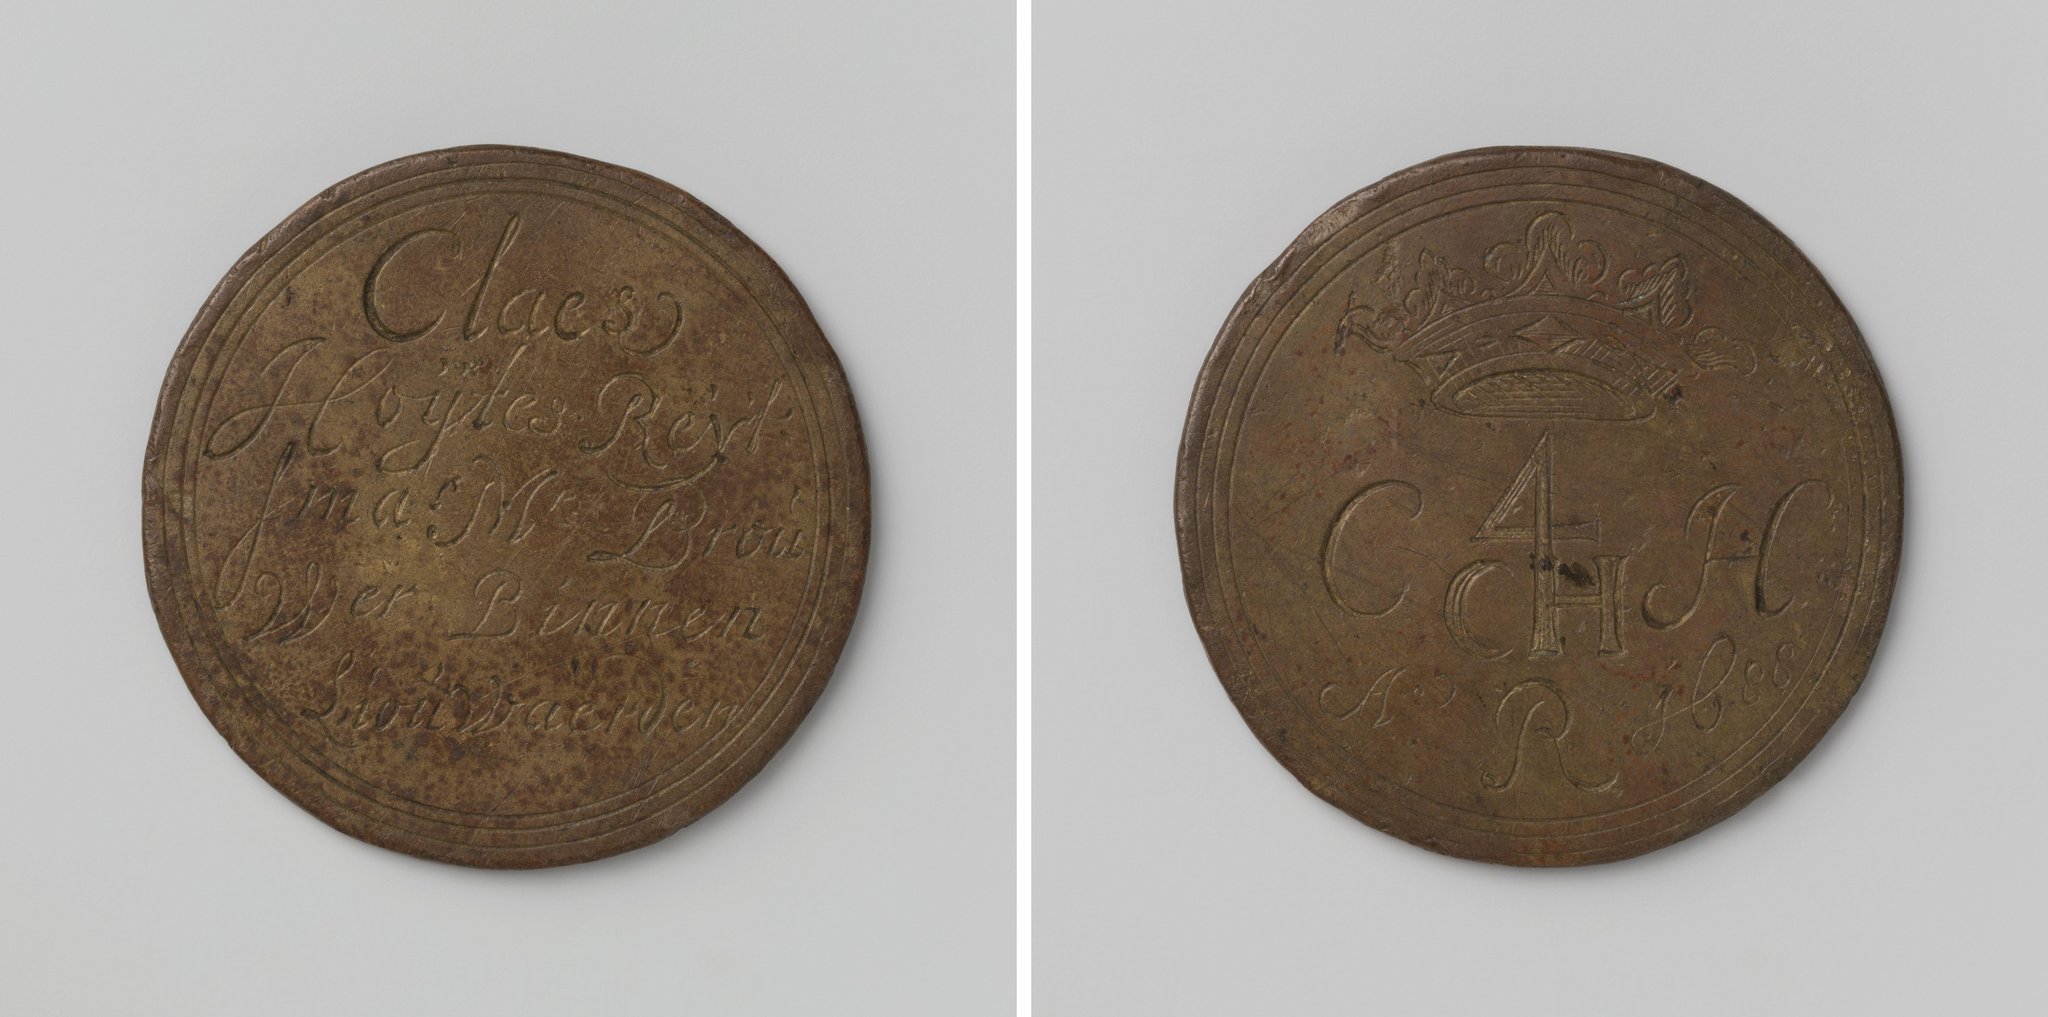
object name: medal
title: Brouwersgilde van Leeuwarden, gildepenning van Claes Hoytes Reytsma, meester brouwer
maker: Anonymous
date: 1688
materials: brass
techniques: engraving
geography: leeuwarden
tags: meester, claes hoytes reytsma, leeuwarden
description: Messing penning. Voorzijde: opschrift. Keerzijde: gekroond huismerk tussen monogram van letters C, H en R; daaromheen: jaartal.